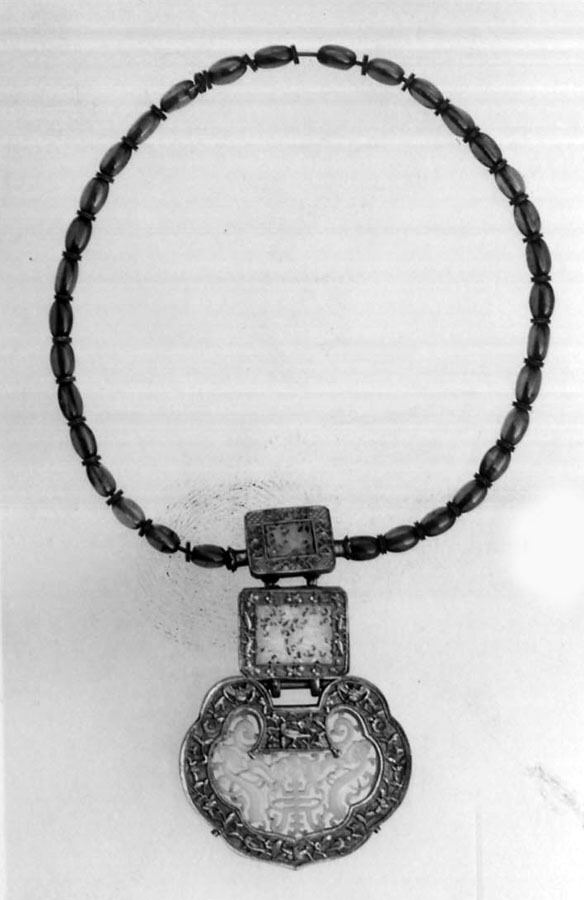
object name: necklace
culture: tibetan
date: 1801-1900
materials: amber, jade, silver